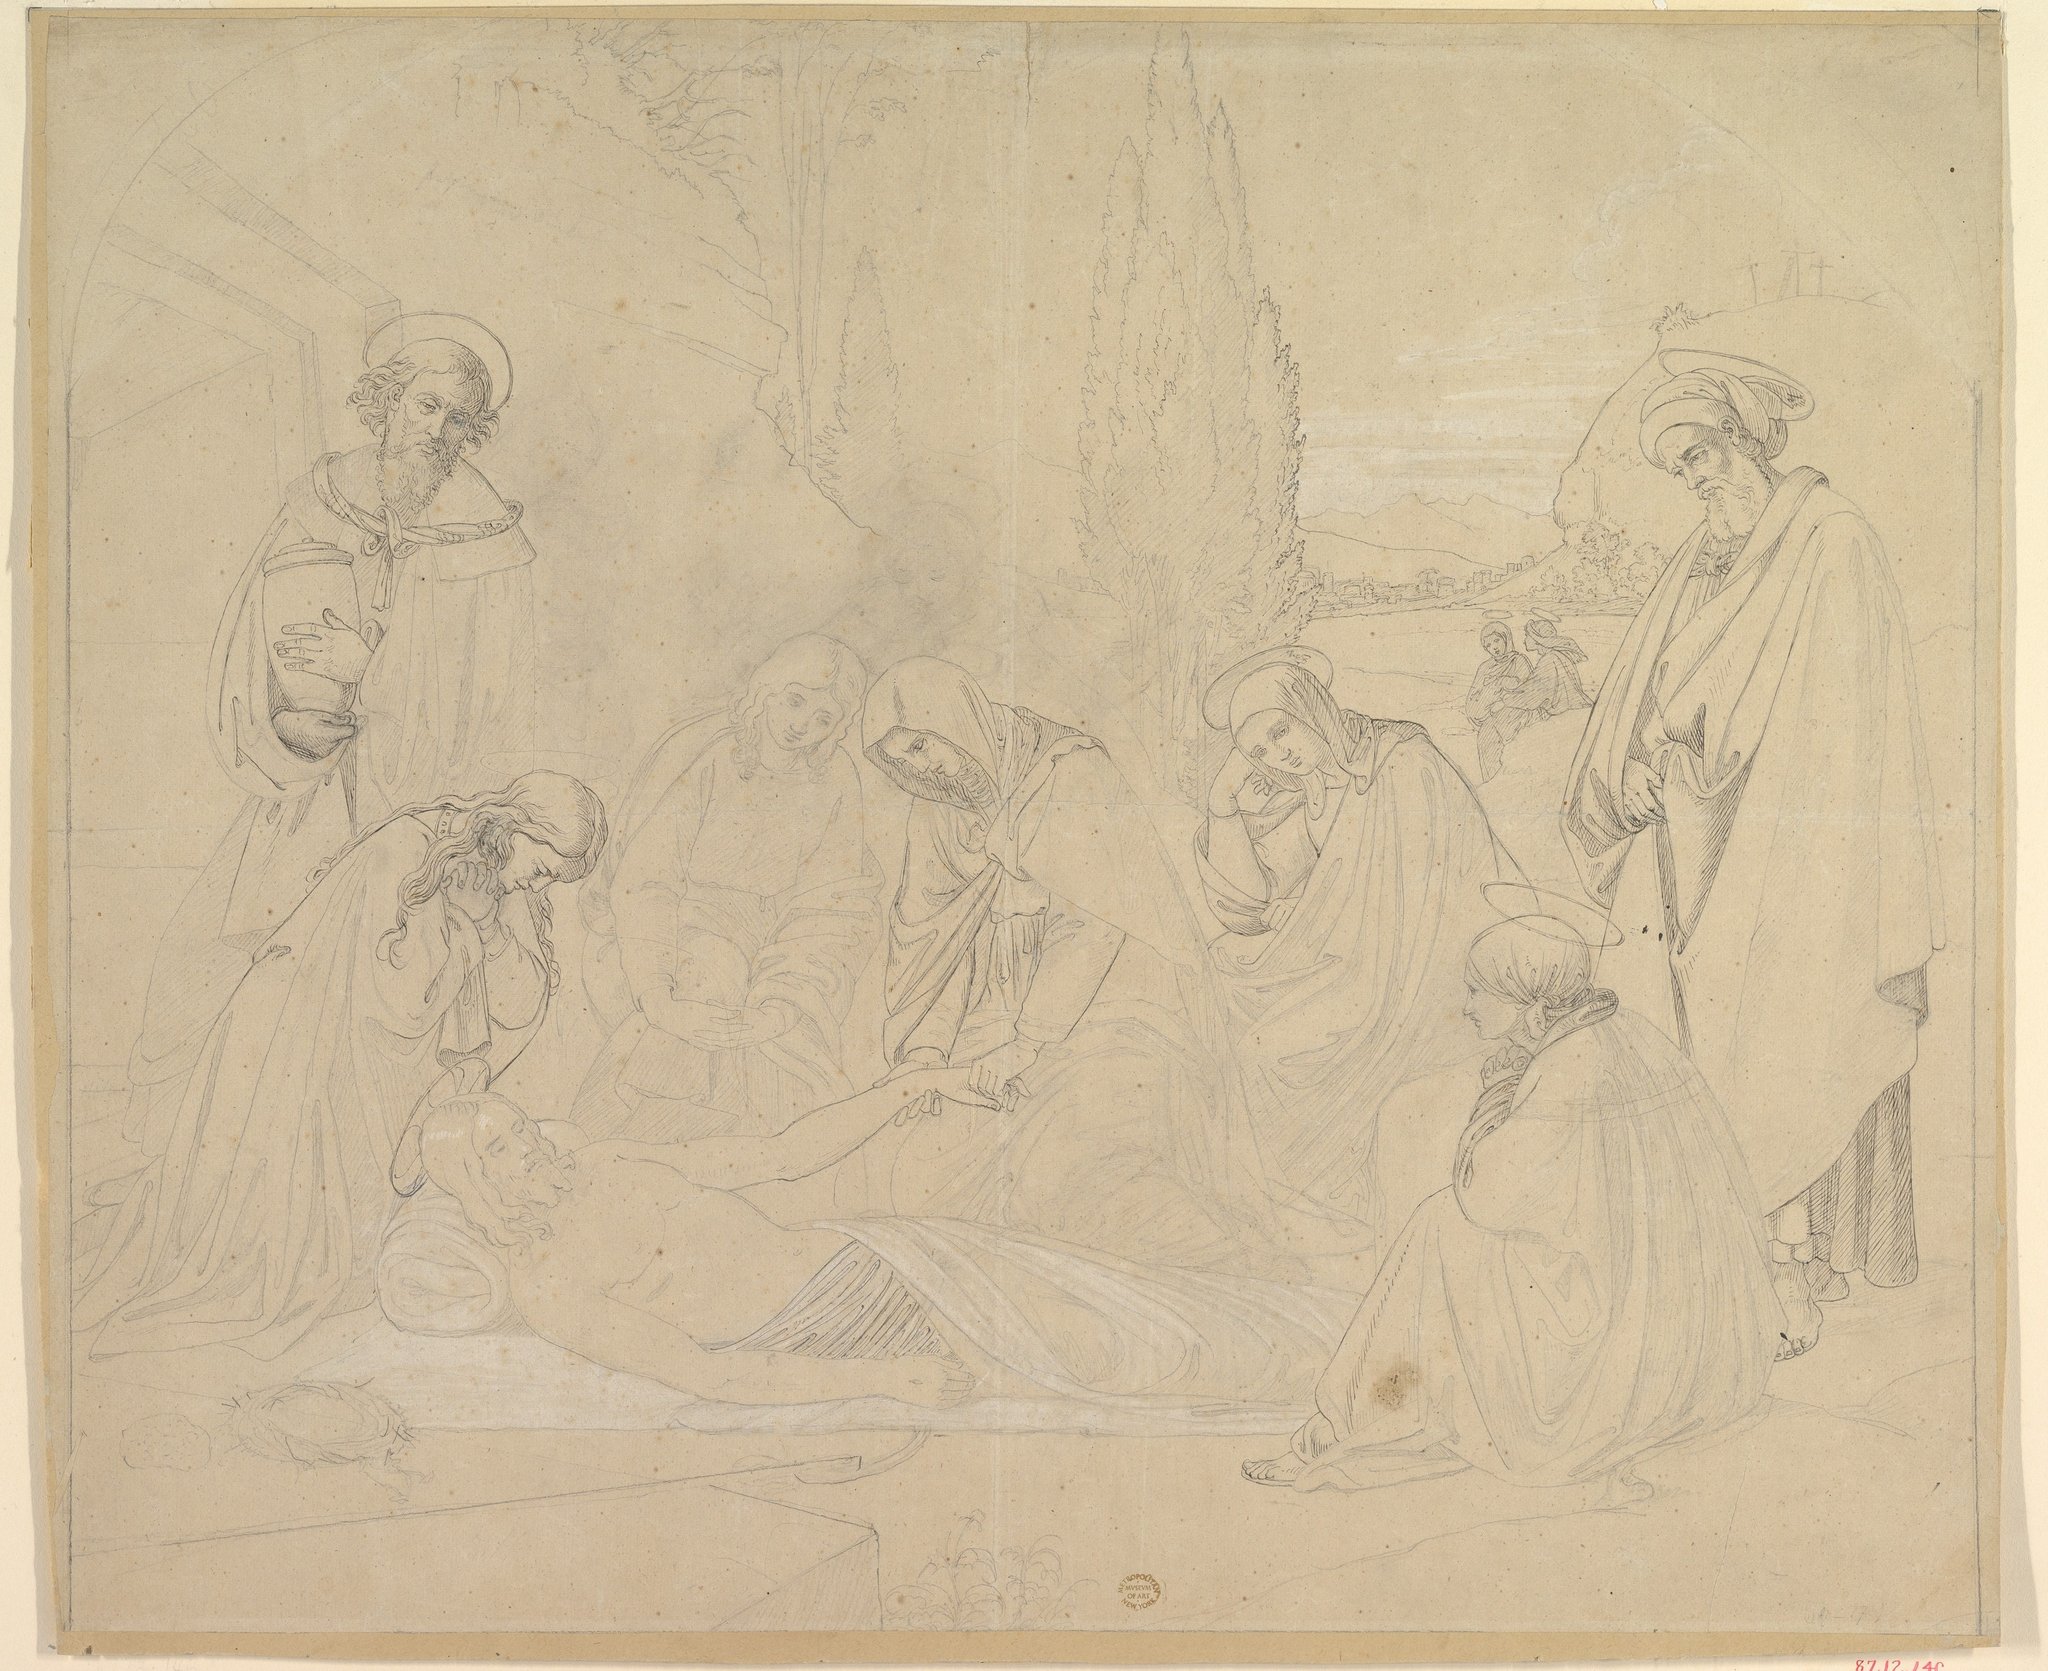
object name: drawing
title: The Lamentation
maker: johann friedrich overbeck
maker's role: artist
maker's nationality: german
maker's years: 1789-1869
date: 1840-1845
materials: graphite, ink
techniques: heightening, pen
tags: lamentation